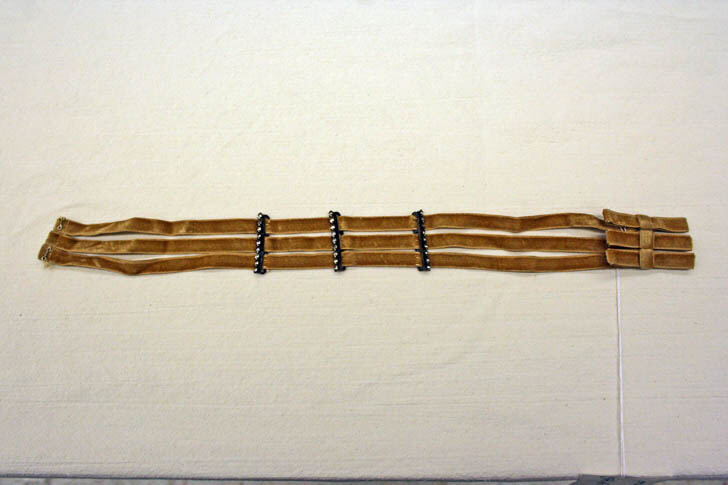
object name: necklace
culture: american or european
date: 1900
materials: silk